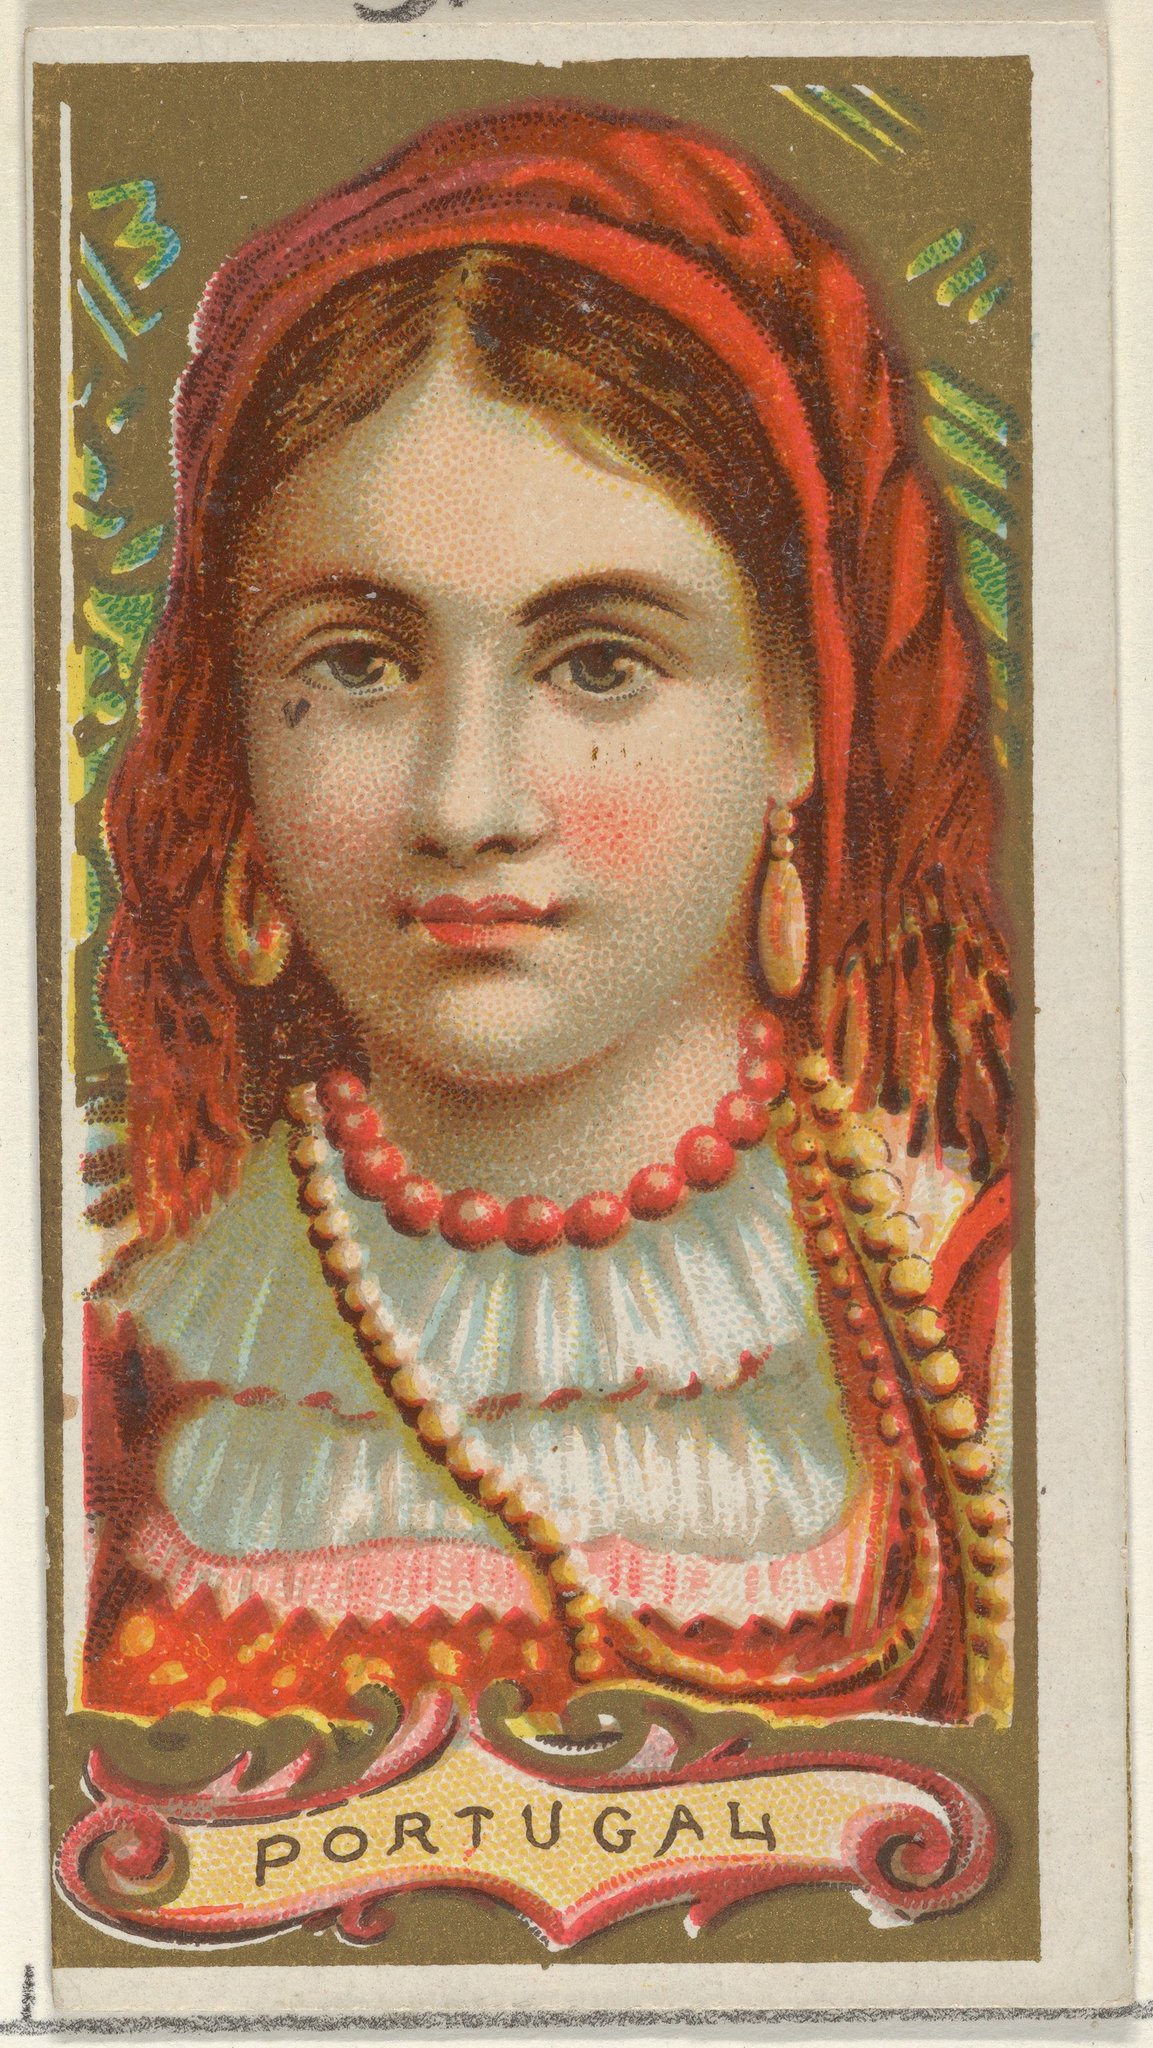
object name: print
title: Portugal, from the Types of All Nations series (N24) for Allen & Ginter Cigarettes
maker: allen & ginter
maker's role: publisher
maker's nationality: american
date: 1889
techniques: color lithograph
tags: women